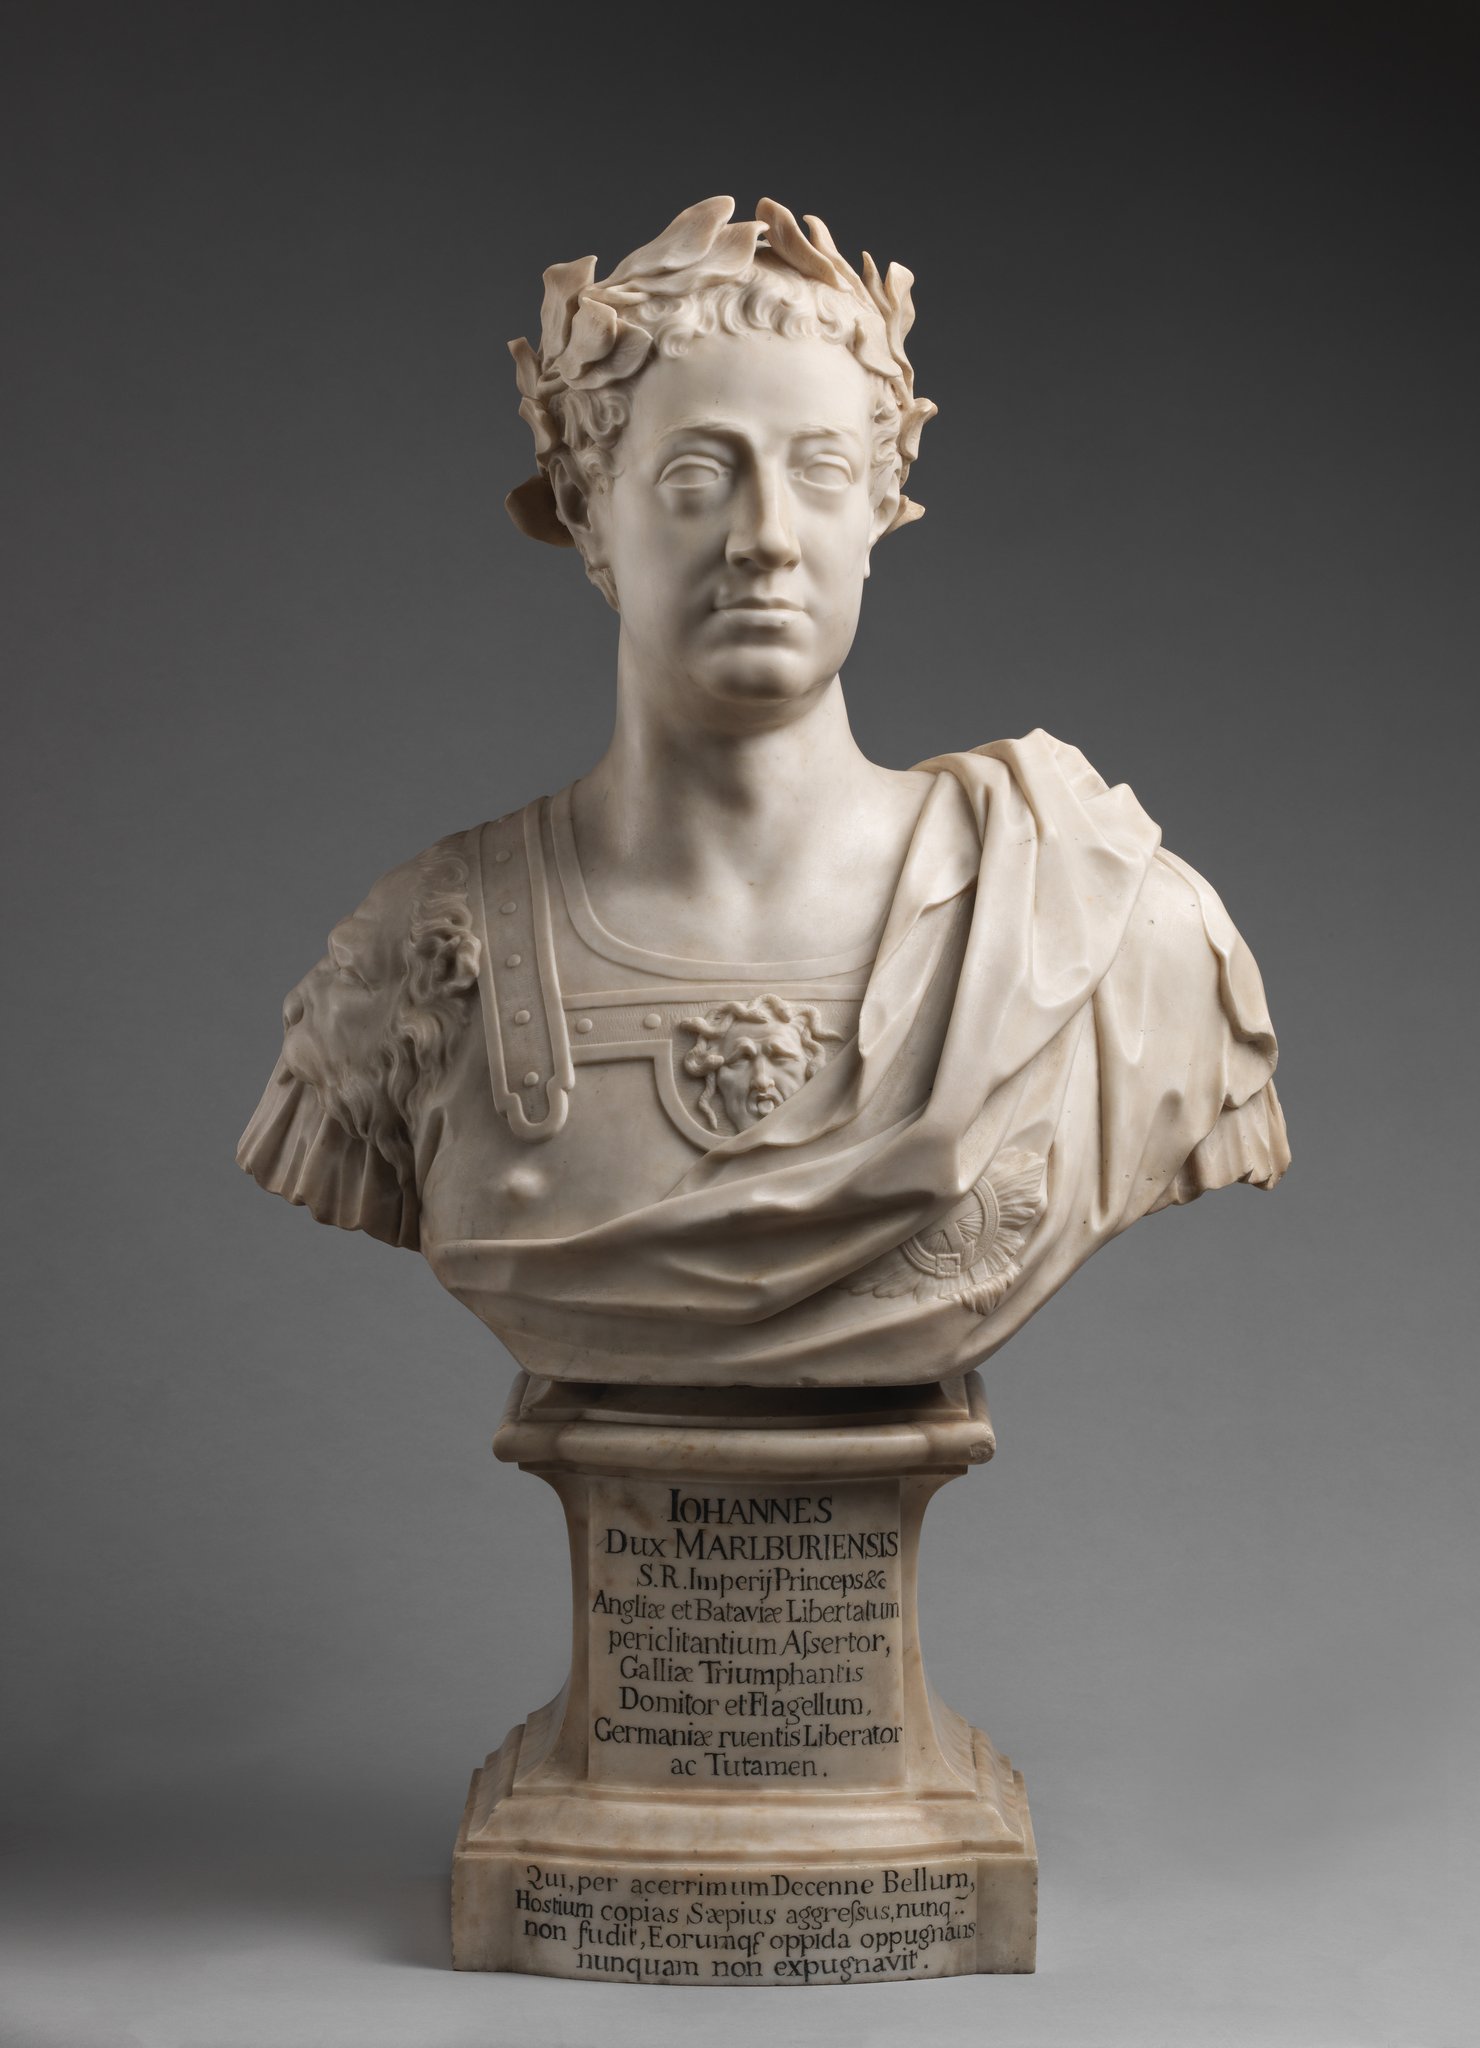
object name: bust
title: John Churchill, 1st Duke of Marlborough (1650–1722)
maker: john michael rysbrack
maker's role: artist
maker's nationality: flemish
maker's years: 1694-1770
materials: marble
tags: men,portraits